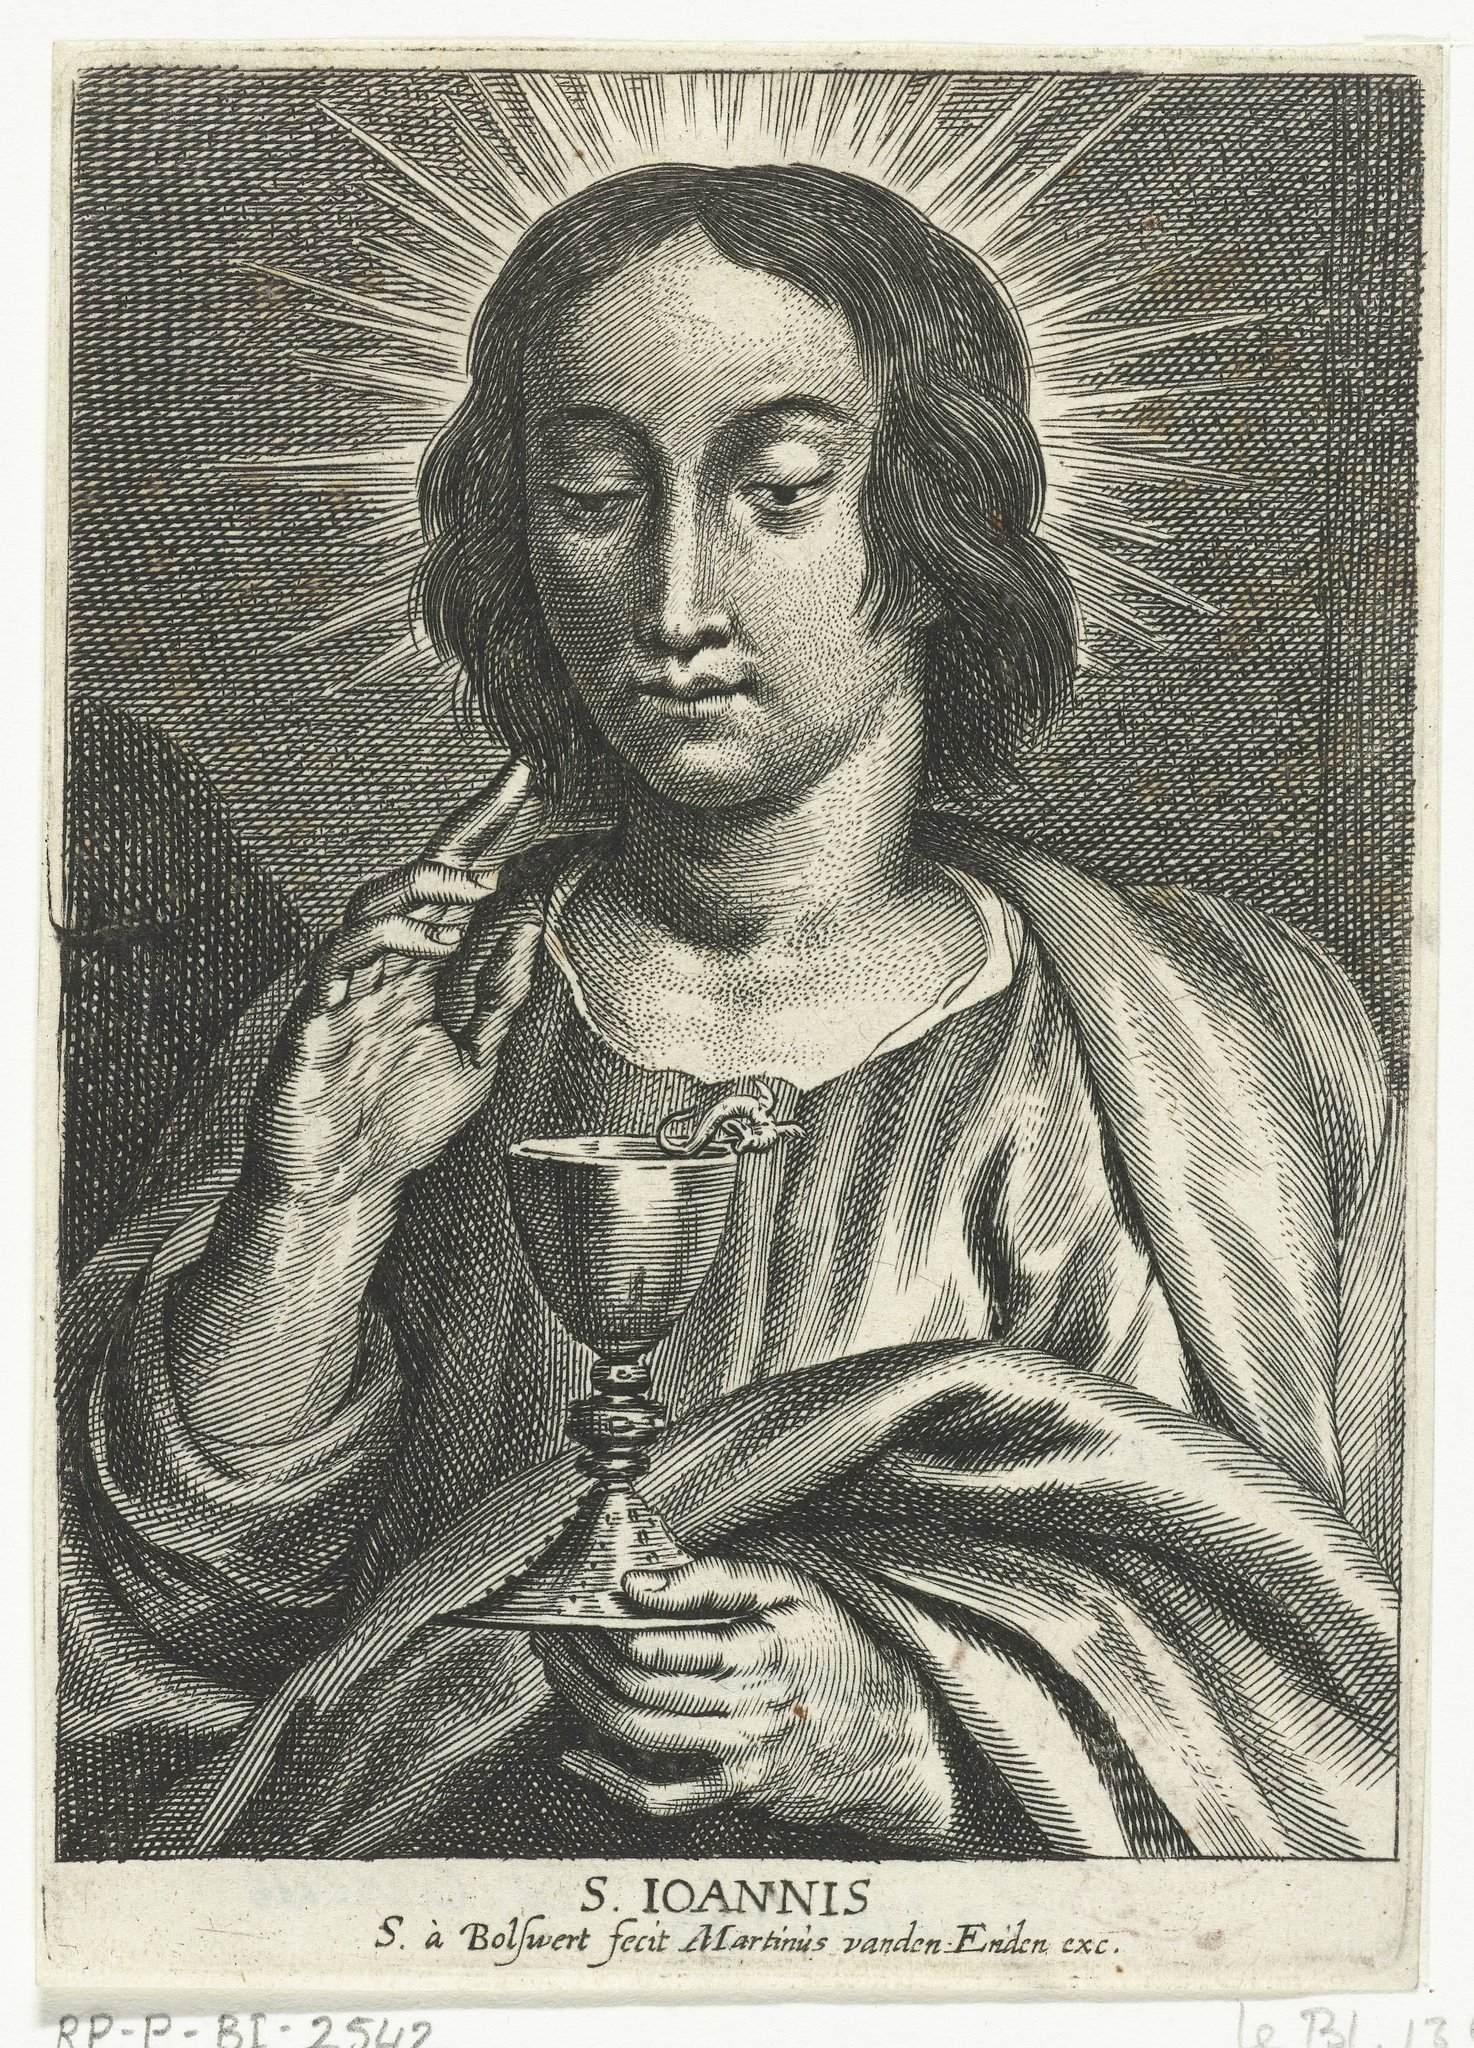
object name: print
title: Vélins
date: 1596-1659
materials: paper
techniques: engraving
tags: the apostle john the evangelist; possible attributes: book, cauldron, chalice with snake, eagle, palm, scroll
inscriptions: collector's mark: Lugt 240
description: Prent uit serie Vélins met negentig prenten naar ontwerp van Peter Paul Rubens. In de bronnen vinden we uiteenlopende gegevens over aantal en samenstelling van de serie. Hollstein hanteert het aantal van negentig prenten. De reeks Vélins in de collectie van het RMA bevat verschillende staten afkomstig uit meerdere uitgaven welke moeilijk te duiden zijn. Sommige dragen het originele adres van Schelte Adamsz. Bolswert als graveur en uitgever, op andere exemplaren is deze naam verwijderd (duidelijk zichtbaar!) en vervangen door de naam Cornelis Galle (II). De prenten met de naam van uitgever Galle zijn vaak opgewerkt. We treffen nog een andere naam van een uitgever bij enkele prent aan: Martien van den Enden. Herkomst uit meerdere uitgaven spreekt ook uit afwijkende opschriften in Nederlands en Latijn en variaties op dezelfde thema's welke misschien nooit langs elkaar in dezelfde serie gebruikt werden.